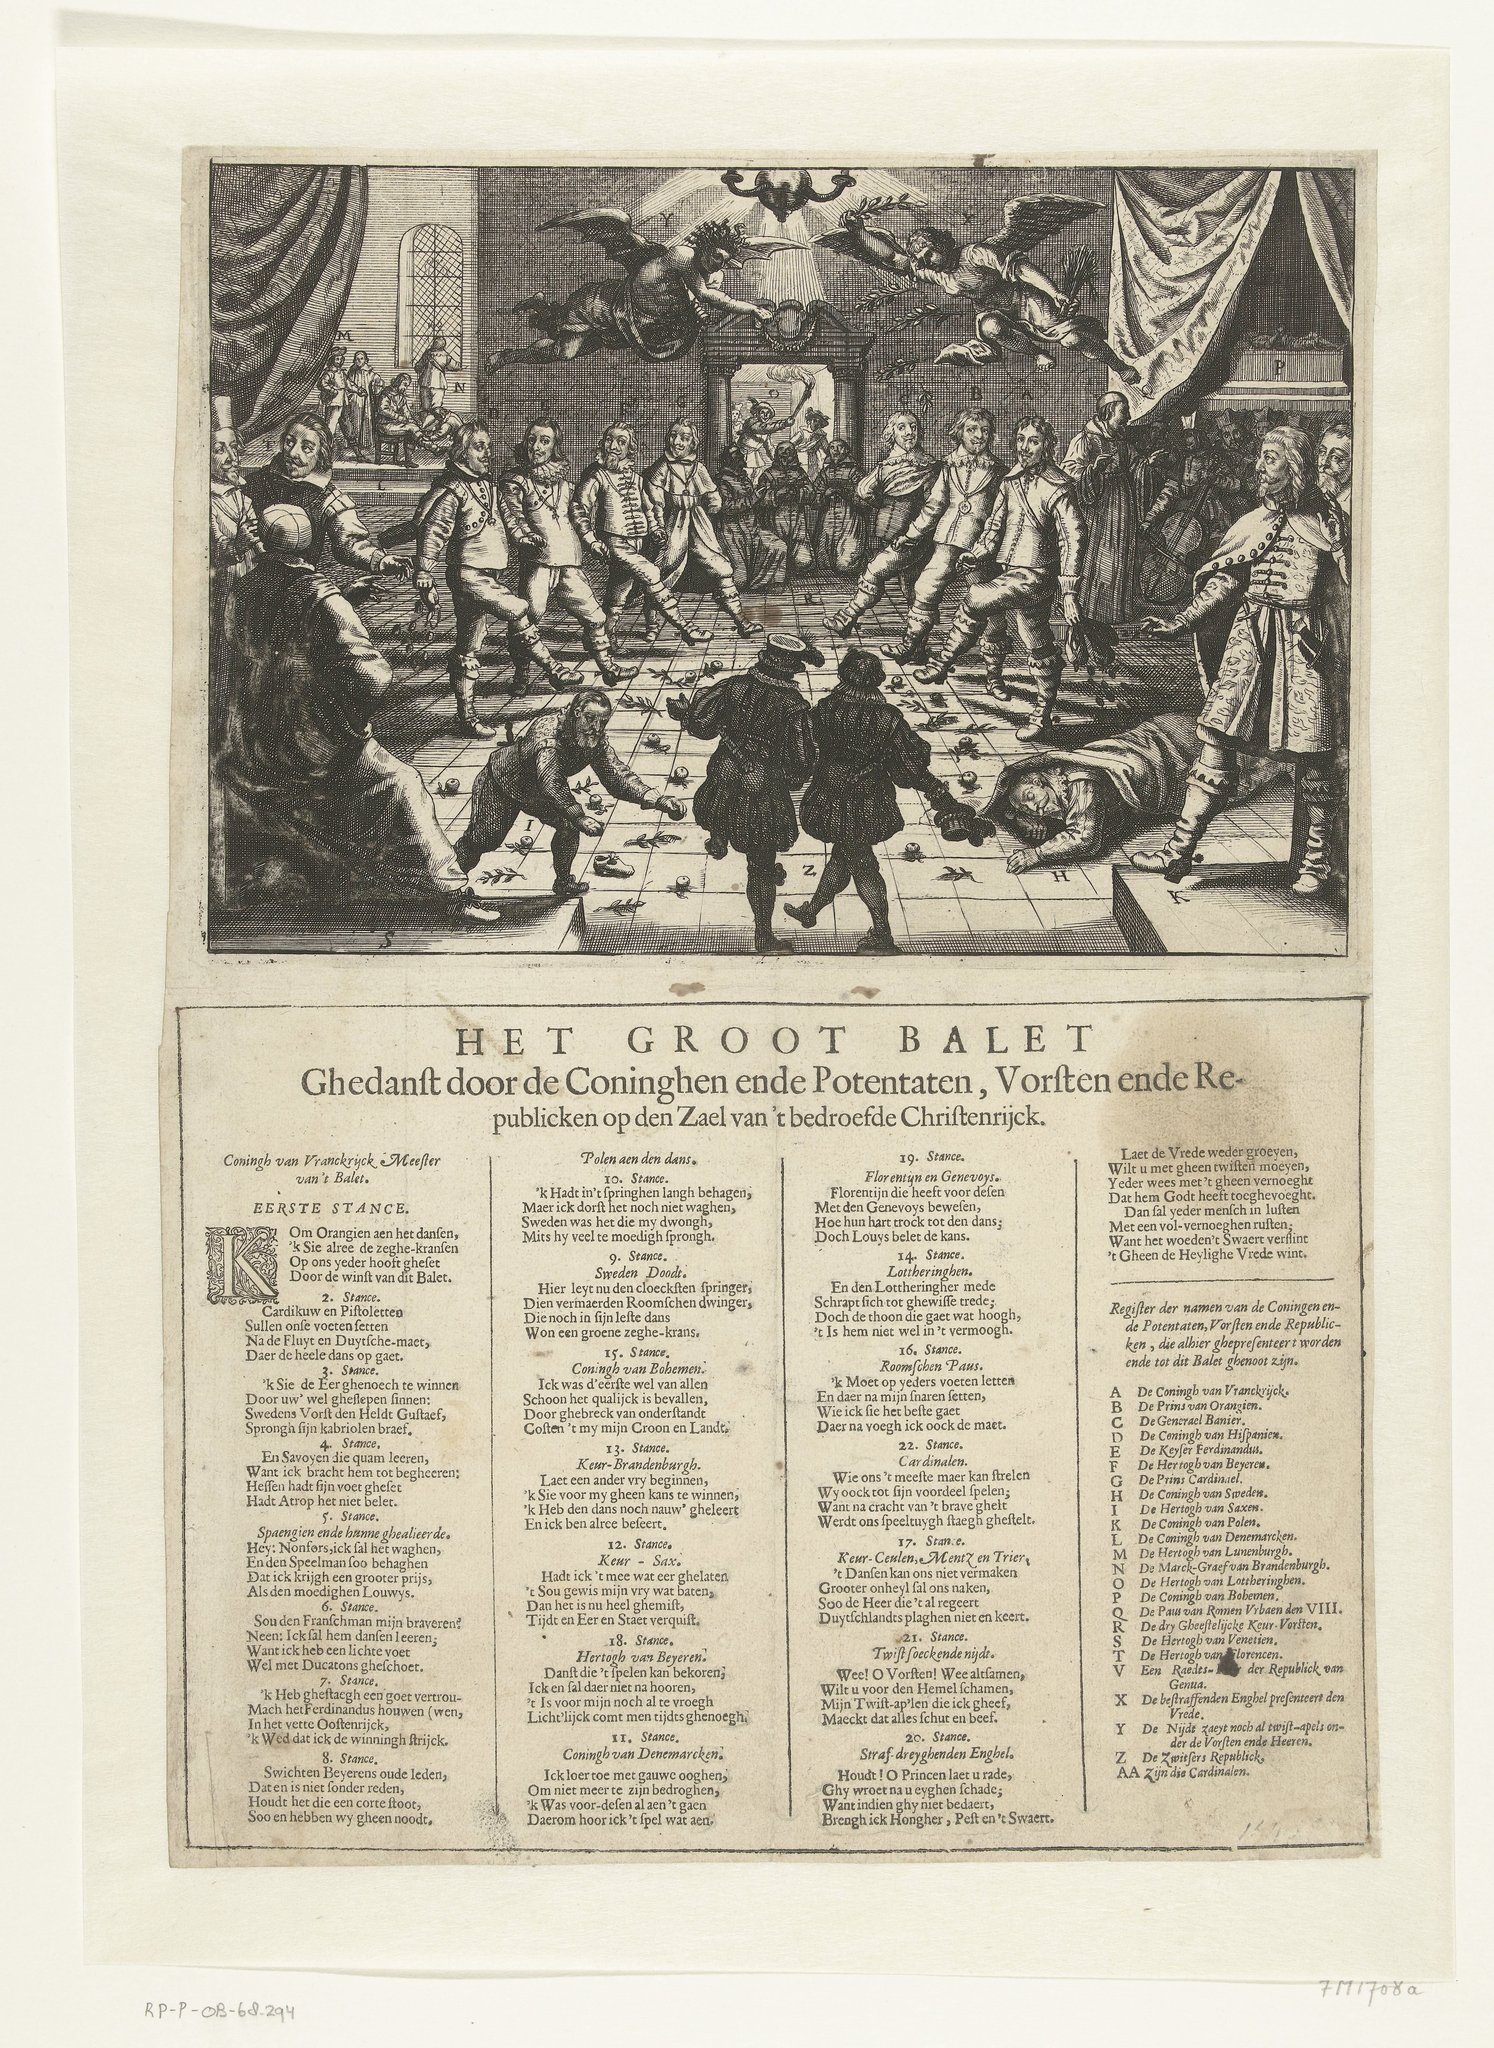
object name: cartoon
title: Spotprent op de vredesonderhandelingen met Spanje, 1632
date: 1632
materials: paper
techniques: engraving, etching, letterpress printing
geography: northern netherlands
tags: delft, the hague, frederick henry (prince of orange), filips iv (koning van spanje), vienna, ferdinand ii (duits keizer), copenhagen (city), christiaan iv (koning van denemarken en noorwegen), rome, urbanus viii, brussels, landvoogd der zuidelijke nederlanden ferdinand van oostenrijk, lodewijk xiii (koning van frankrijk), peace negotiations, group dancing, political caricatures and satires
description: Spotprent op de vredesonderhandelingen met Spanje, 1632. Balzaal waarin de Europese vorsten samen dansen. Op de vloer liggen olijftakken en twistappels, gestrooid door de Vrede en de Nijd die in de lucht vliegen. Rechts de Franse koning Lodewijk XIII, prins Frederik Hendrik en de Zweedse generaal Torstenson (Banier), links de Spaanse koning Filips IV, keizer Ferdinand II, de hertog van Beieren en de Kardinaal-Infant Ferdinand van Oostenrijk. Op de voorgrond kijken toe links de hertogen van Venetië, Florence en Genua en rechts de koning van Polen. Dood onder een kleed ligt Gustaaf II Adolf, koning van Zweden. Op de achtergrond rechts speelt een orkestje van jezuïeten onder leiding van paus Urbanus VIII. Op de achtergrond links krijgt de Deense koning Christiaan IV een verband om het been. Onder de plaat een blad met een lied in 20 coupletten en de legenda A-AA in het Nederlands.